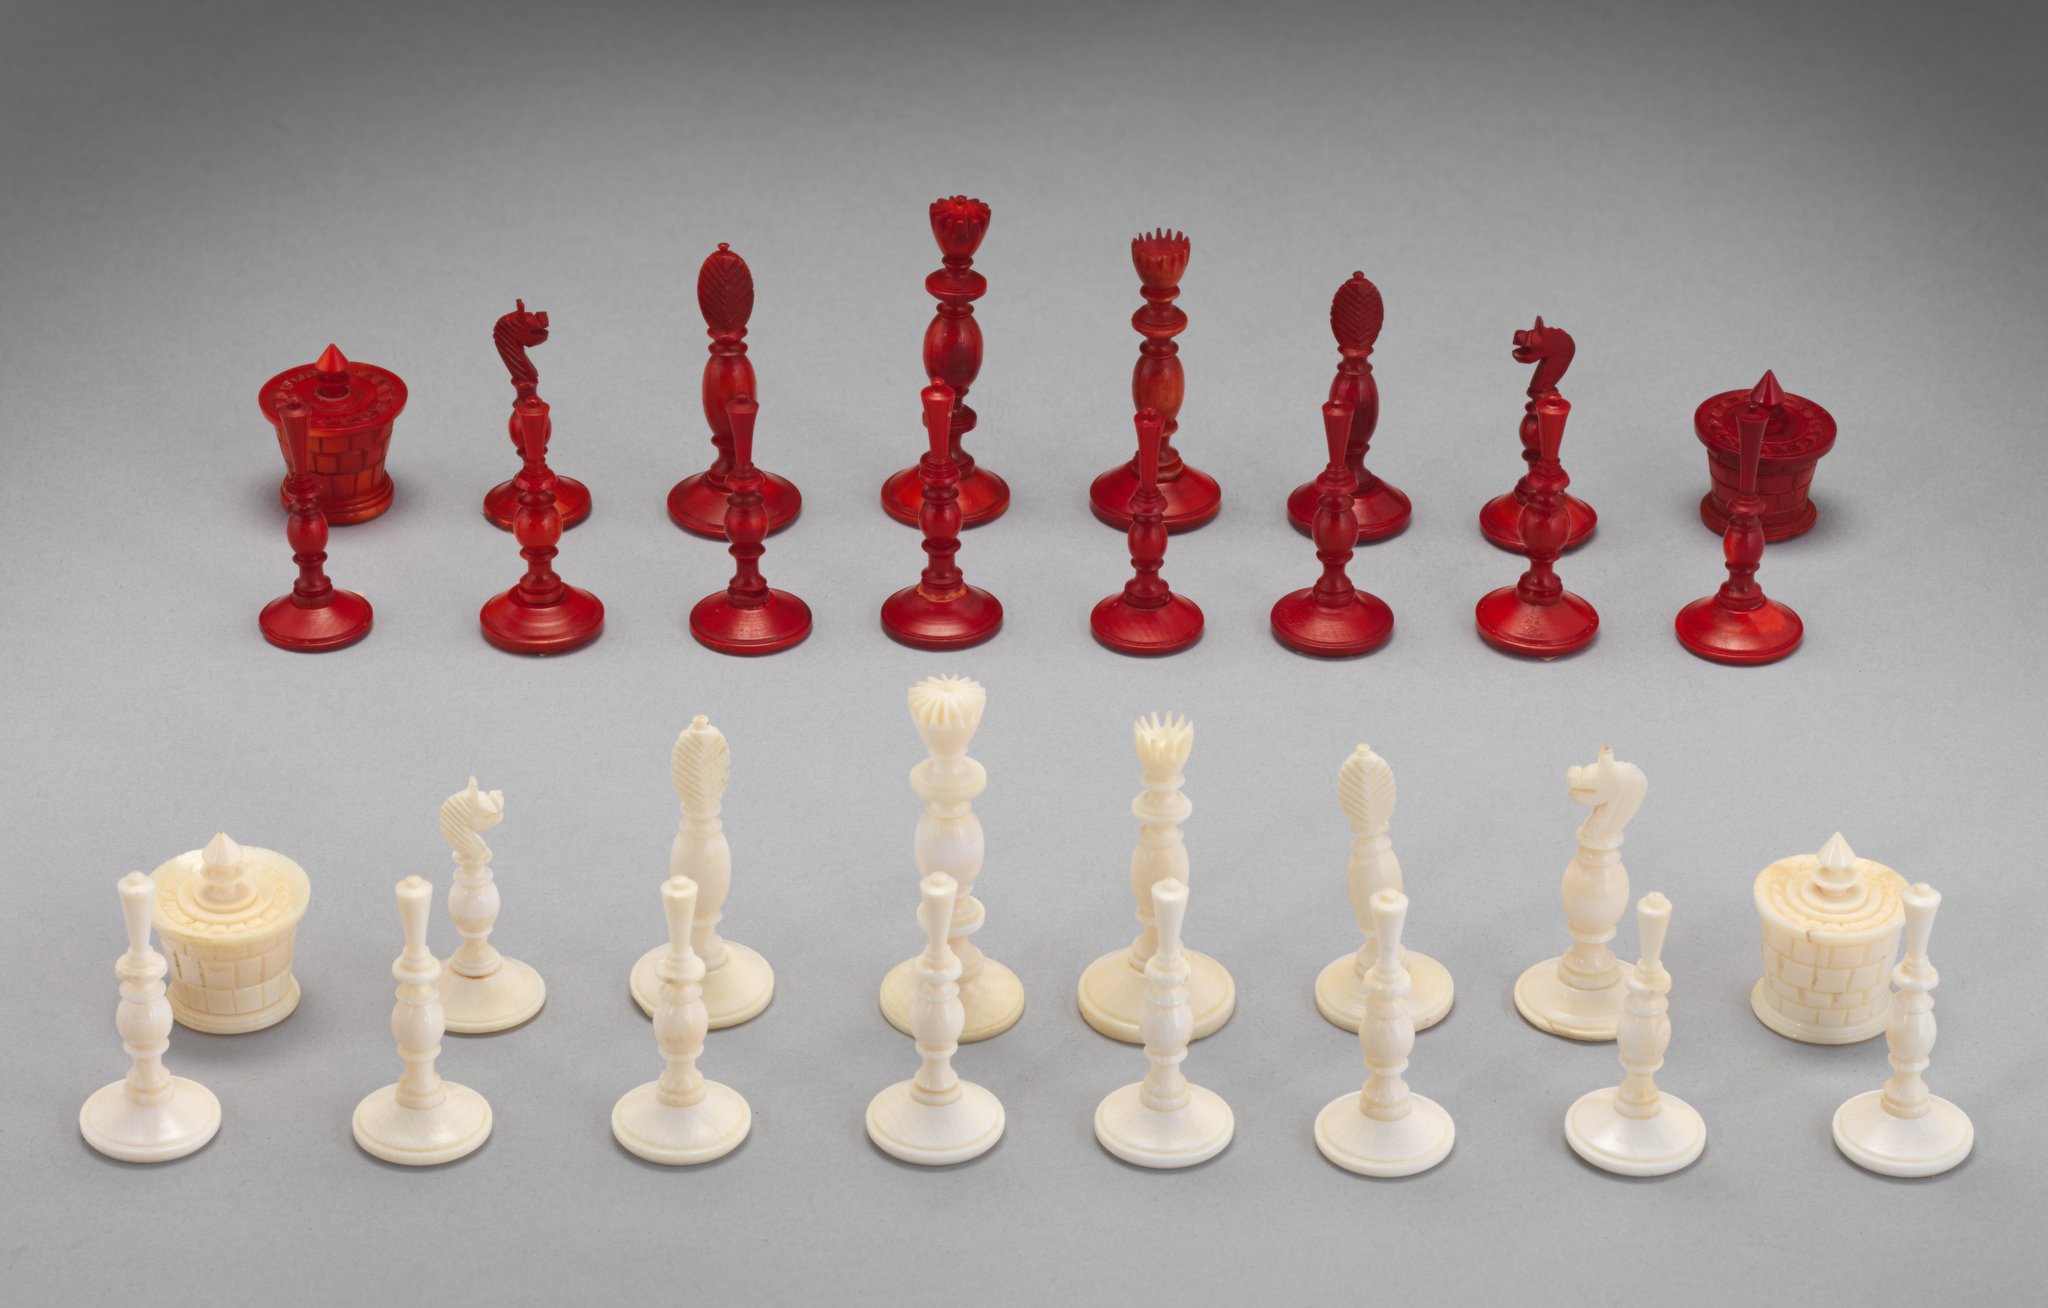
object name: chessman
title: Chessmen (32)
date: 1801-1900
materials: ivory